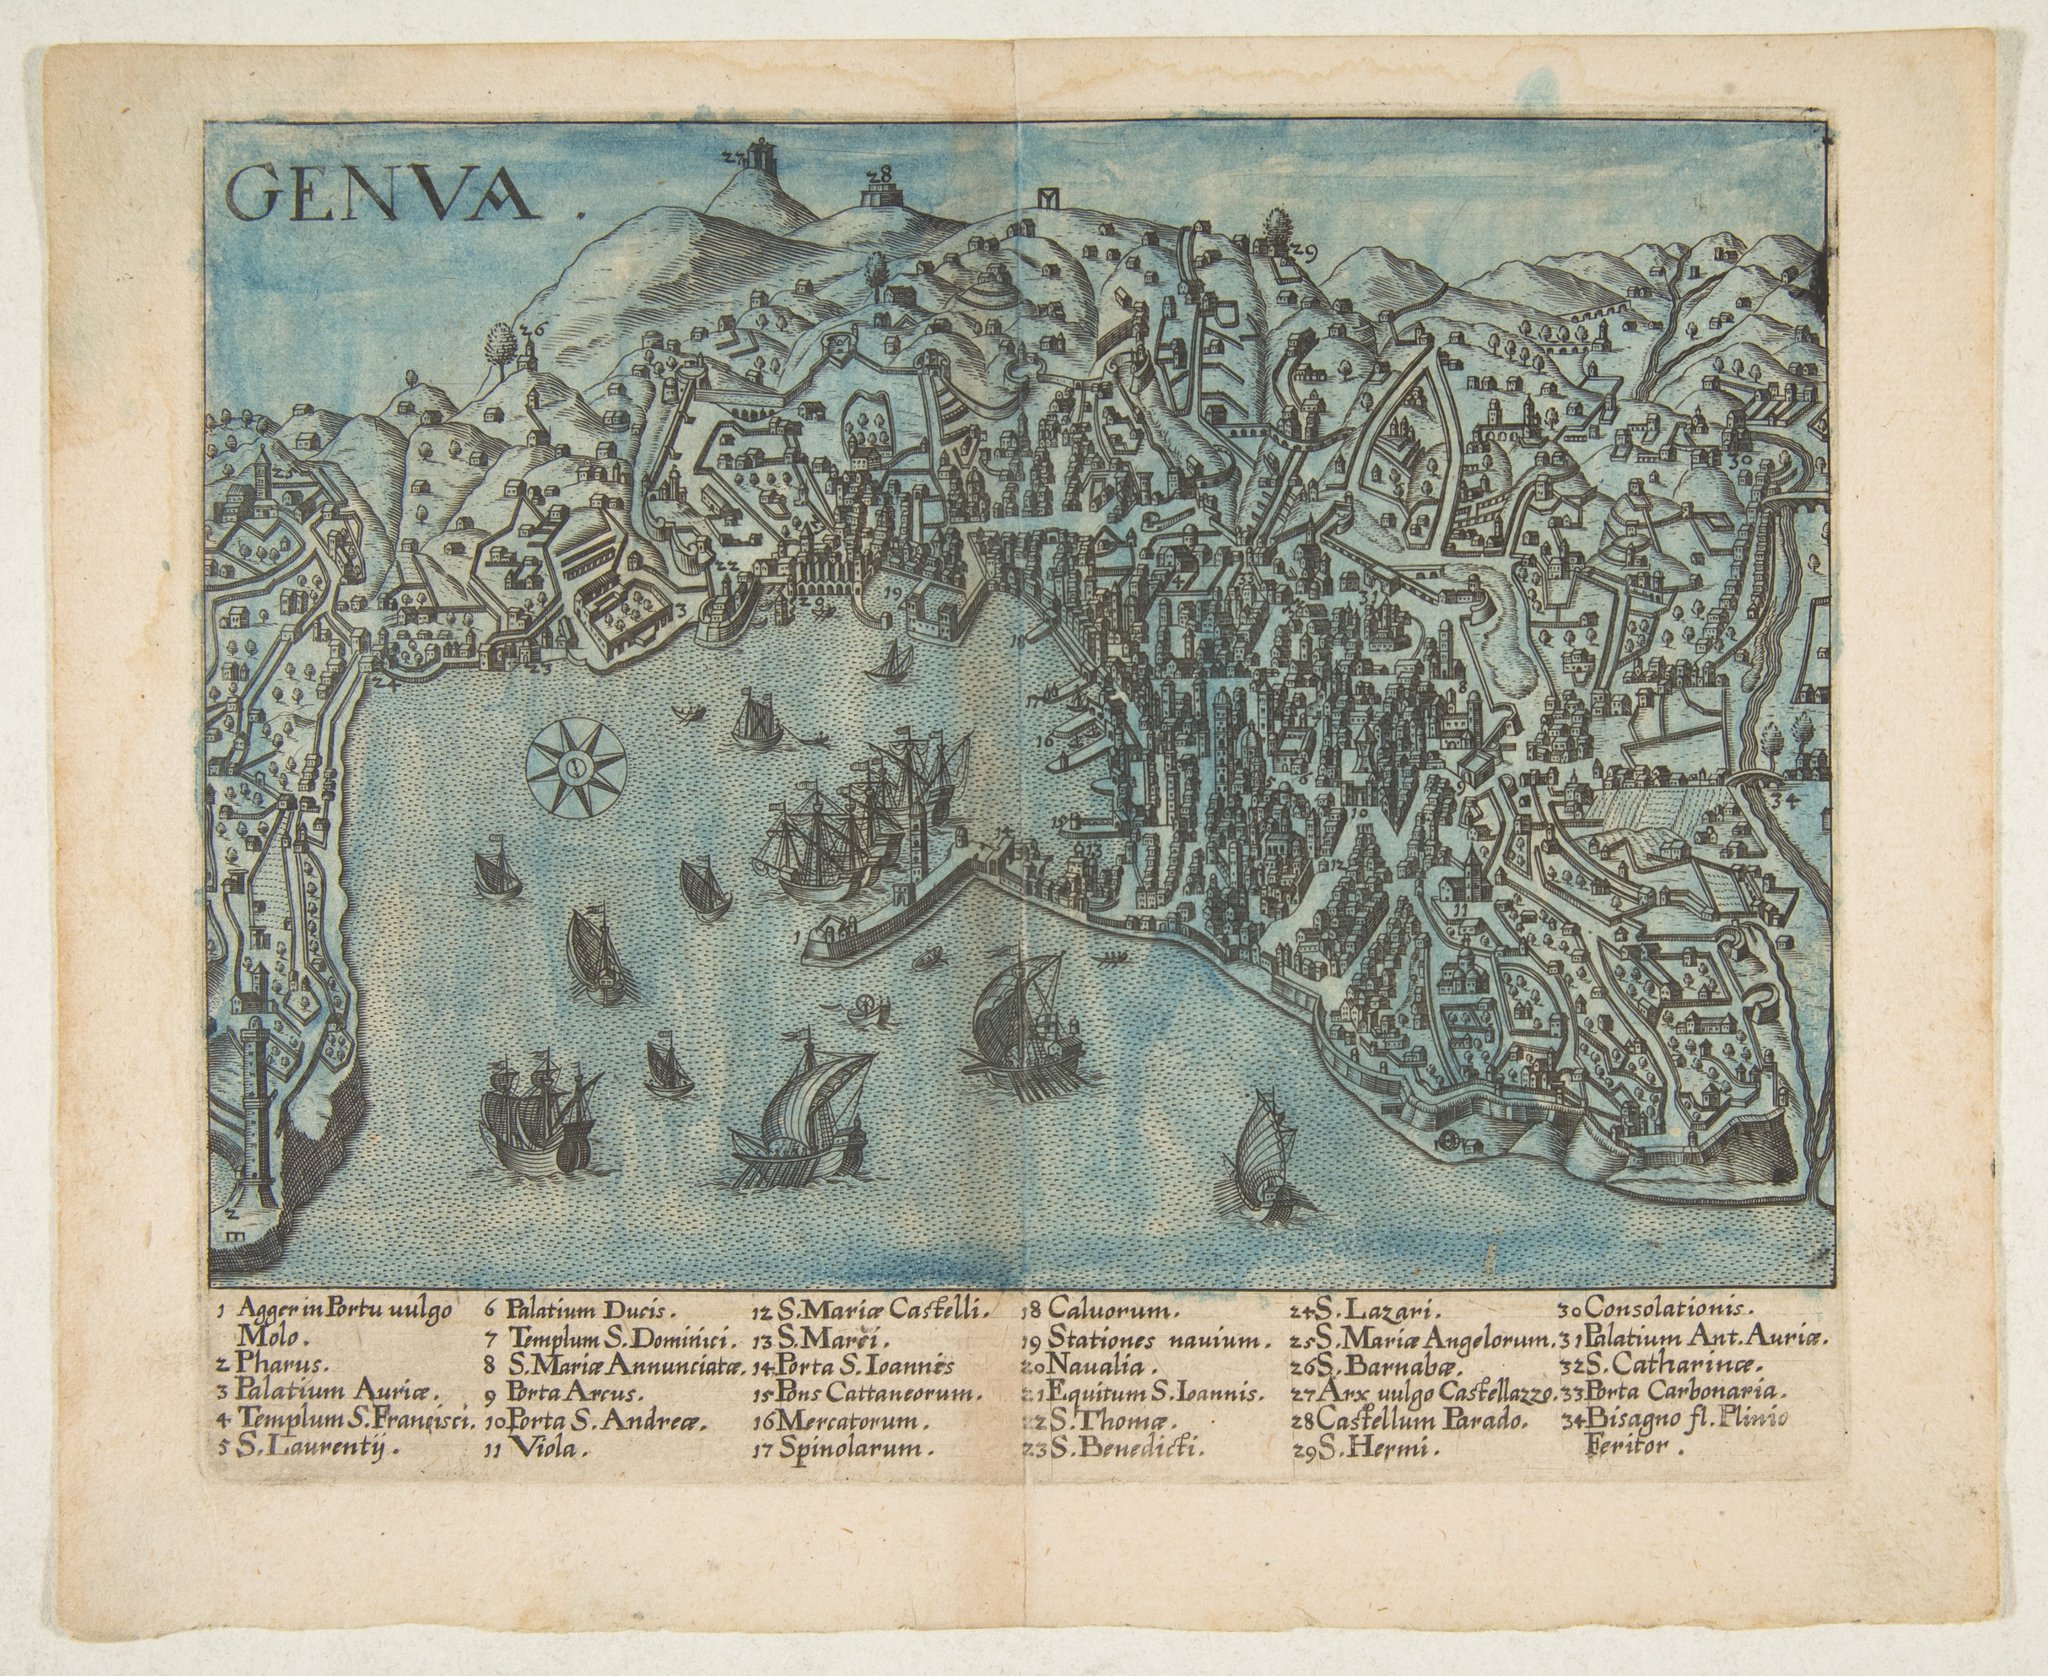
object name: print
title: View of Genoa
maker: anonymous, italian, 17th century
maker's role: artist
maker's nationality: italian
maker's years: 1600-1700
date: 1604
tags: cities,maps